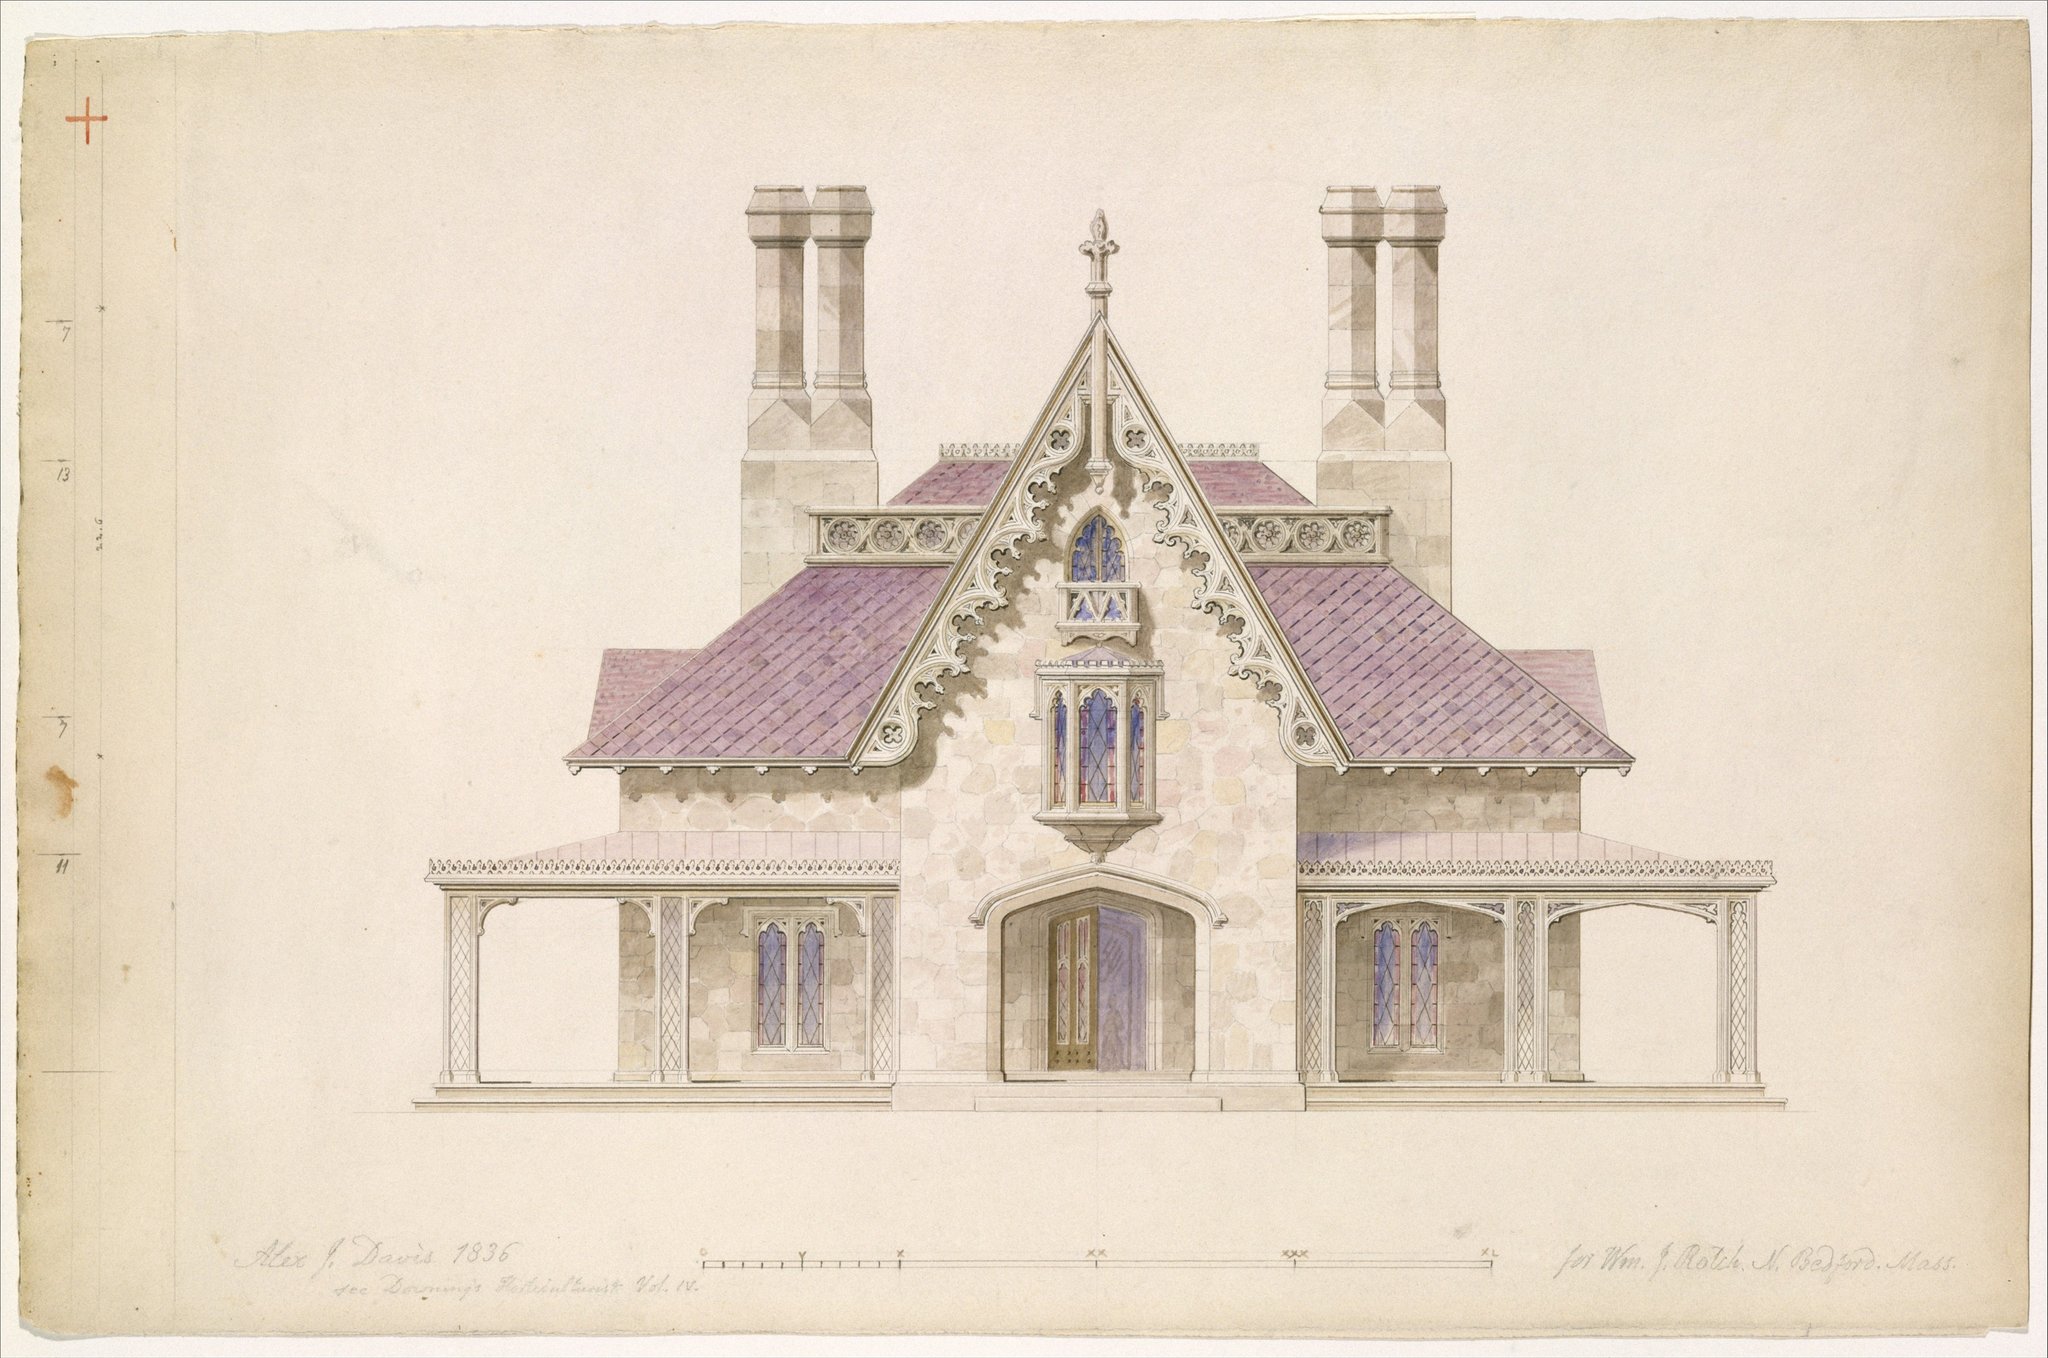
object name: drawing ornament architecture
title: House for William J. Rotch, New Bedford, Massachusetts (front elevation)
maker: alexander jackson davis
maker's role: artist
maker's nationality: american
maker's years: 1803-1892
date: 1845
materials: graphite, ink, watercolor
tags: houses